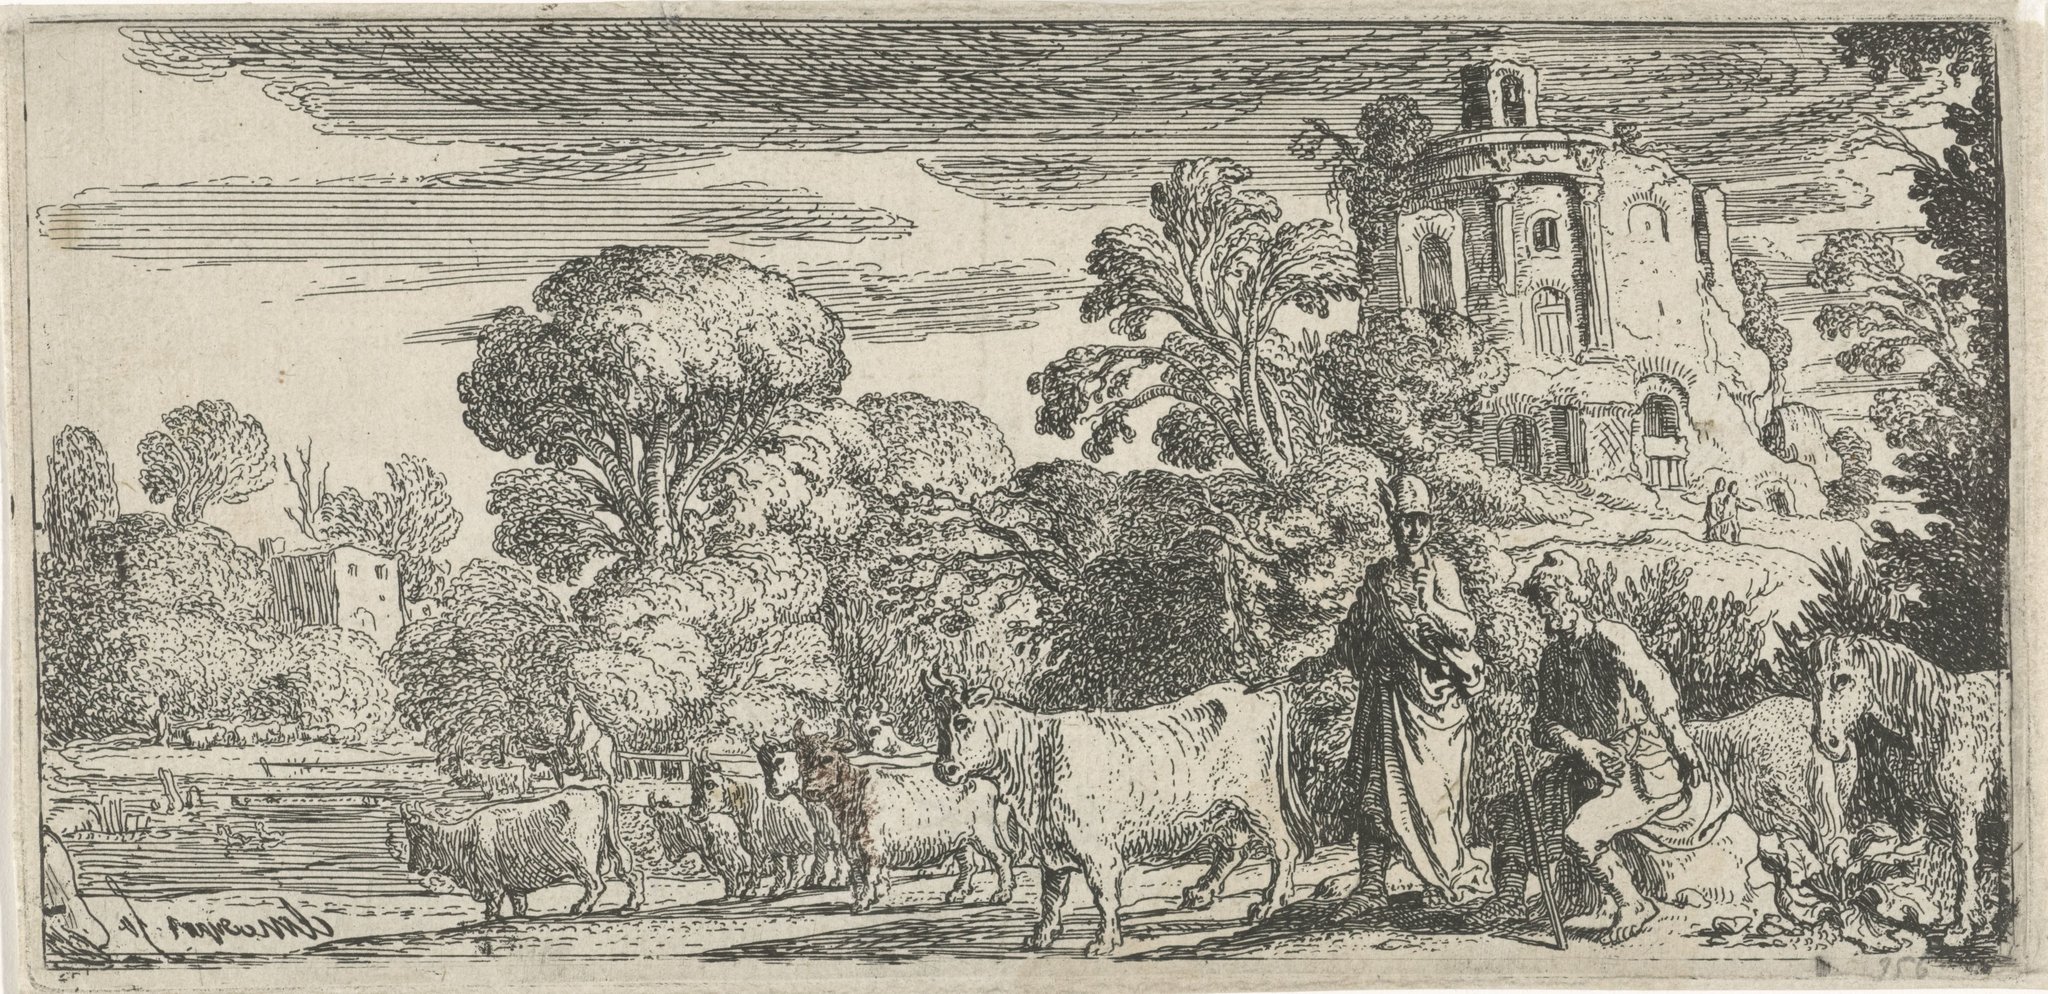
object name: print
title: Mercurius en Battus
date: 1612-1655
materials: paper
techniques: etching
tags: mercury and battus; battus is bribed with a heifer as hush-money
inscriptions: collector's mark: Lugt 2228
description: Mercurius steelt het vee van Apollo en draagt de oude boer Battus op, die de diefstal ziet, om te zwijgen. Rechts op de achtergrond een ronde ruïne.